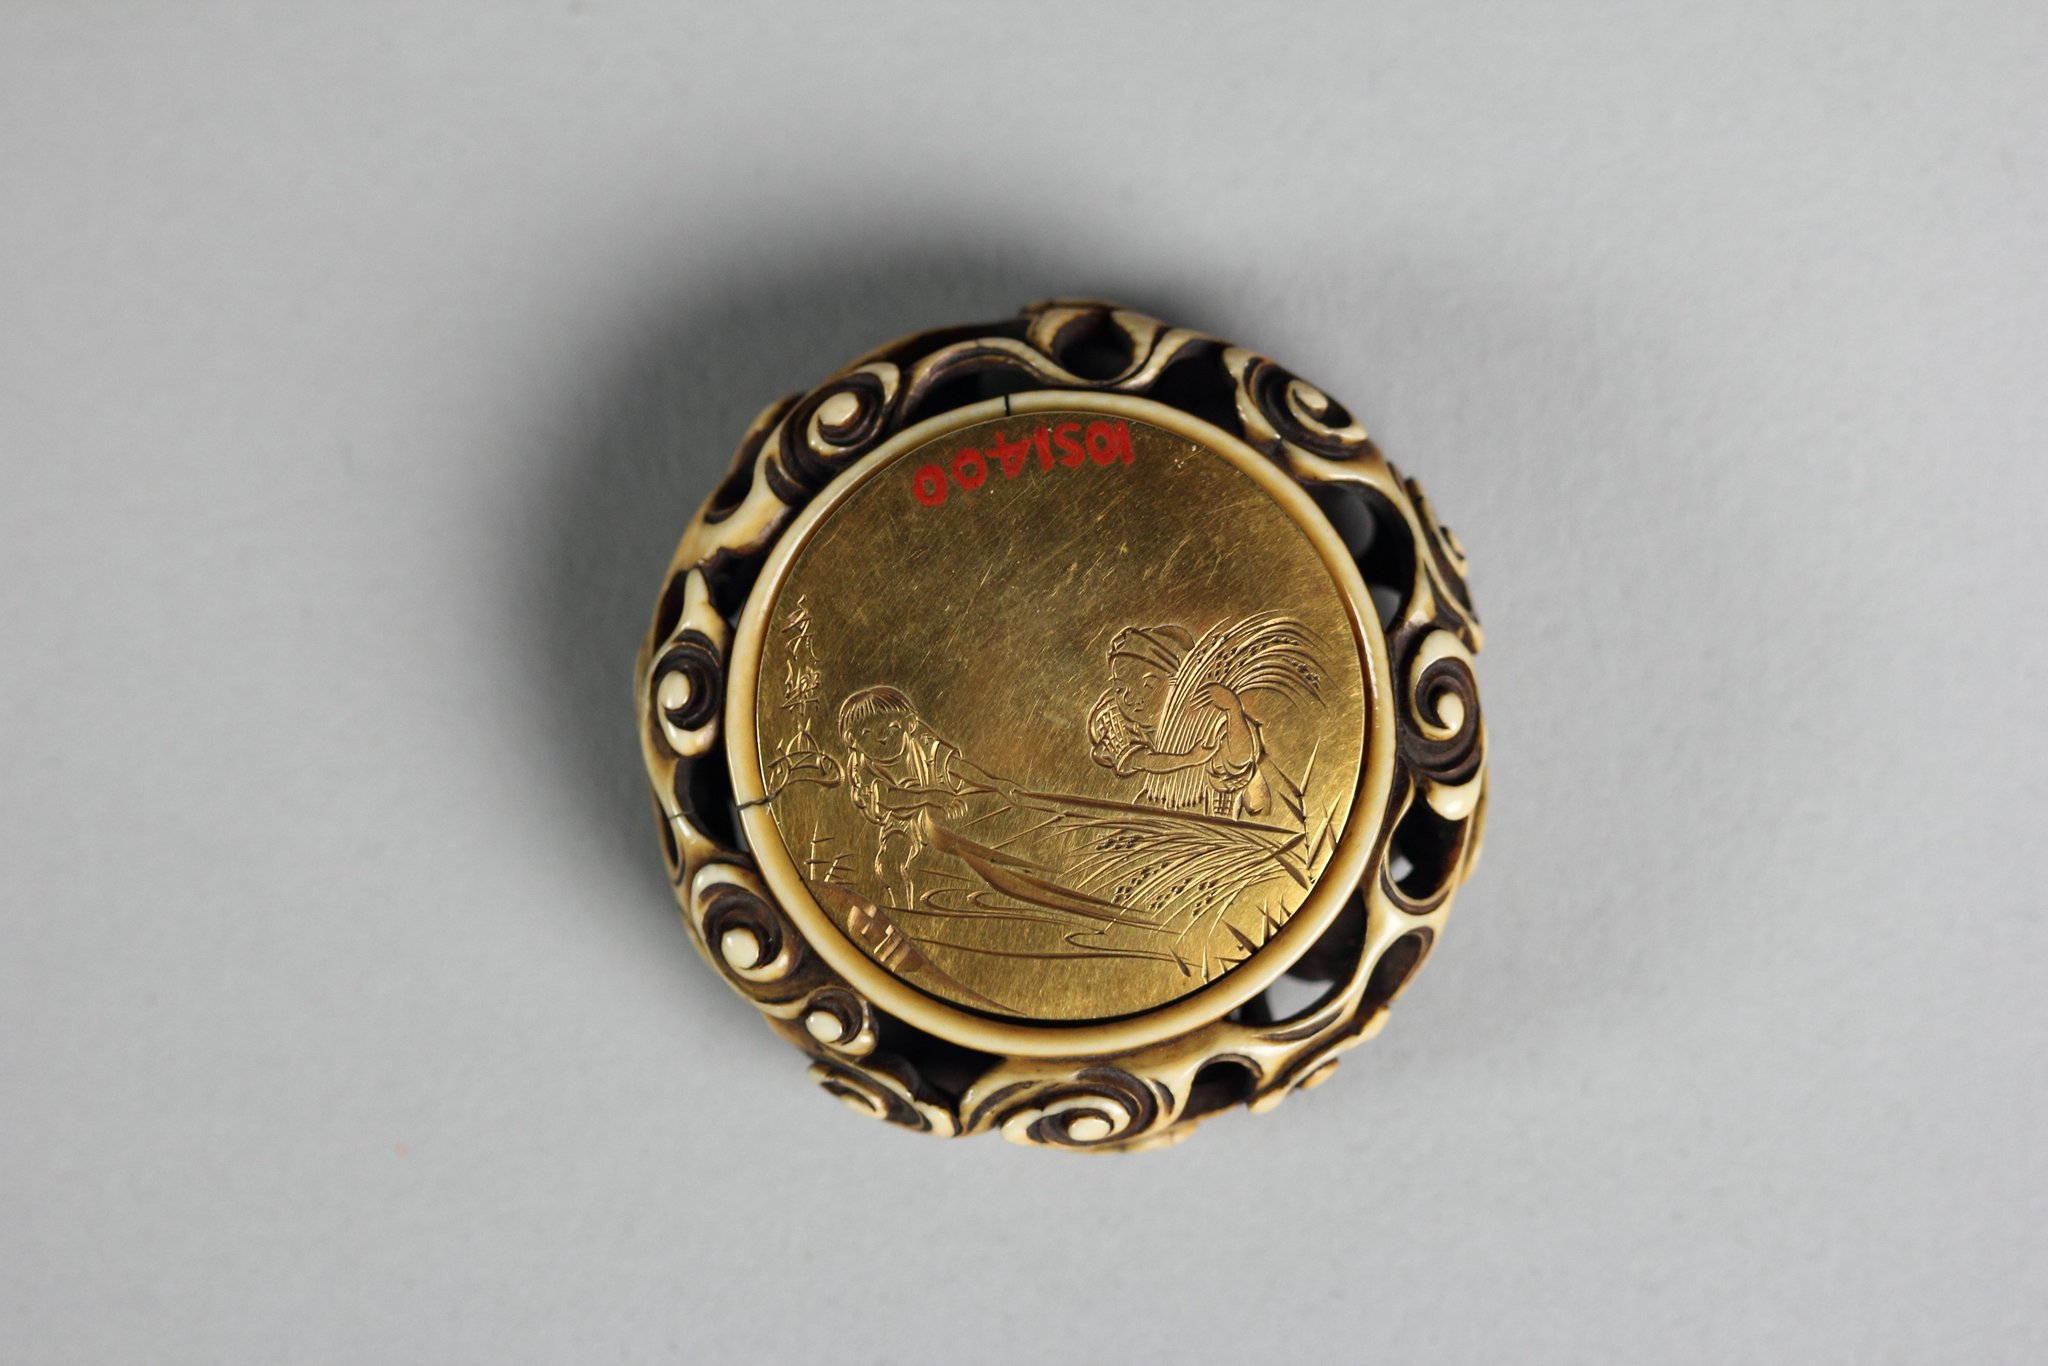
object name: netsuke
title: Netsuke of Peasant and Child Loading a Boat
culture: japanese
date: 1801-1900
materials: gold, ivory, metal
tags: human figures